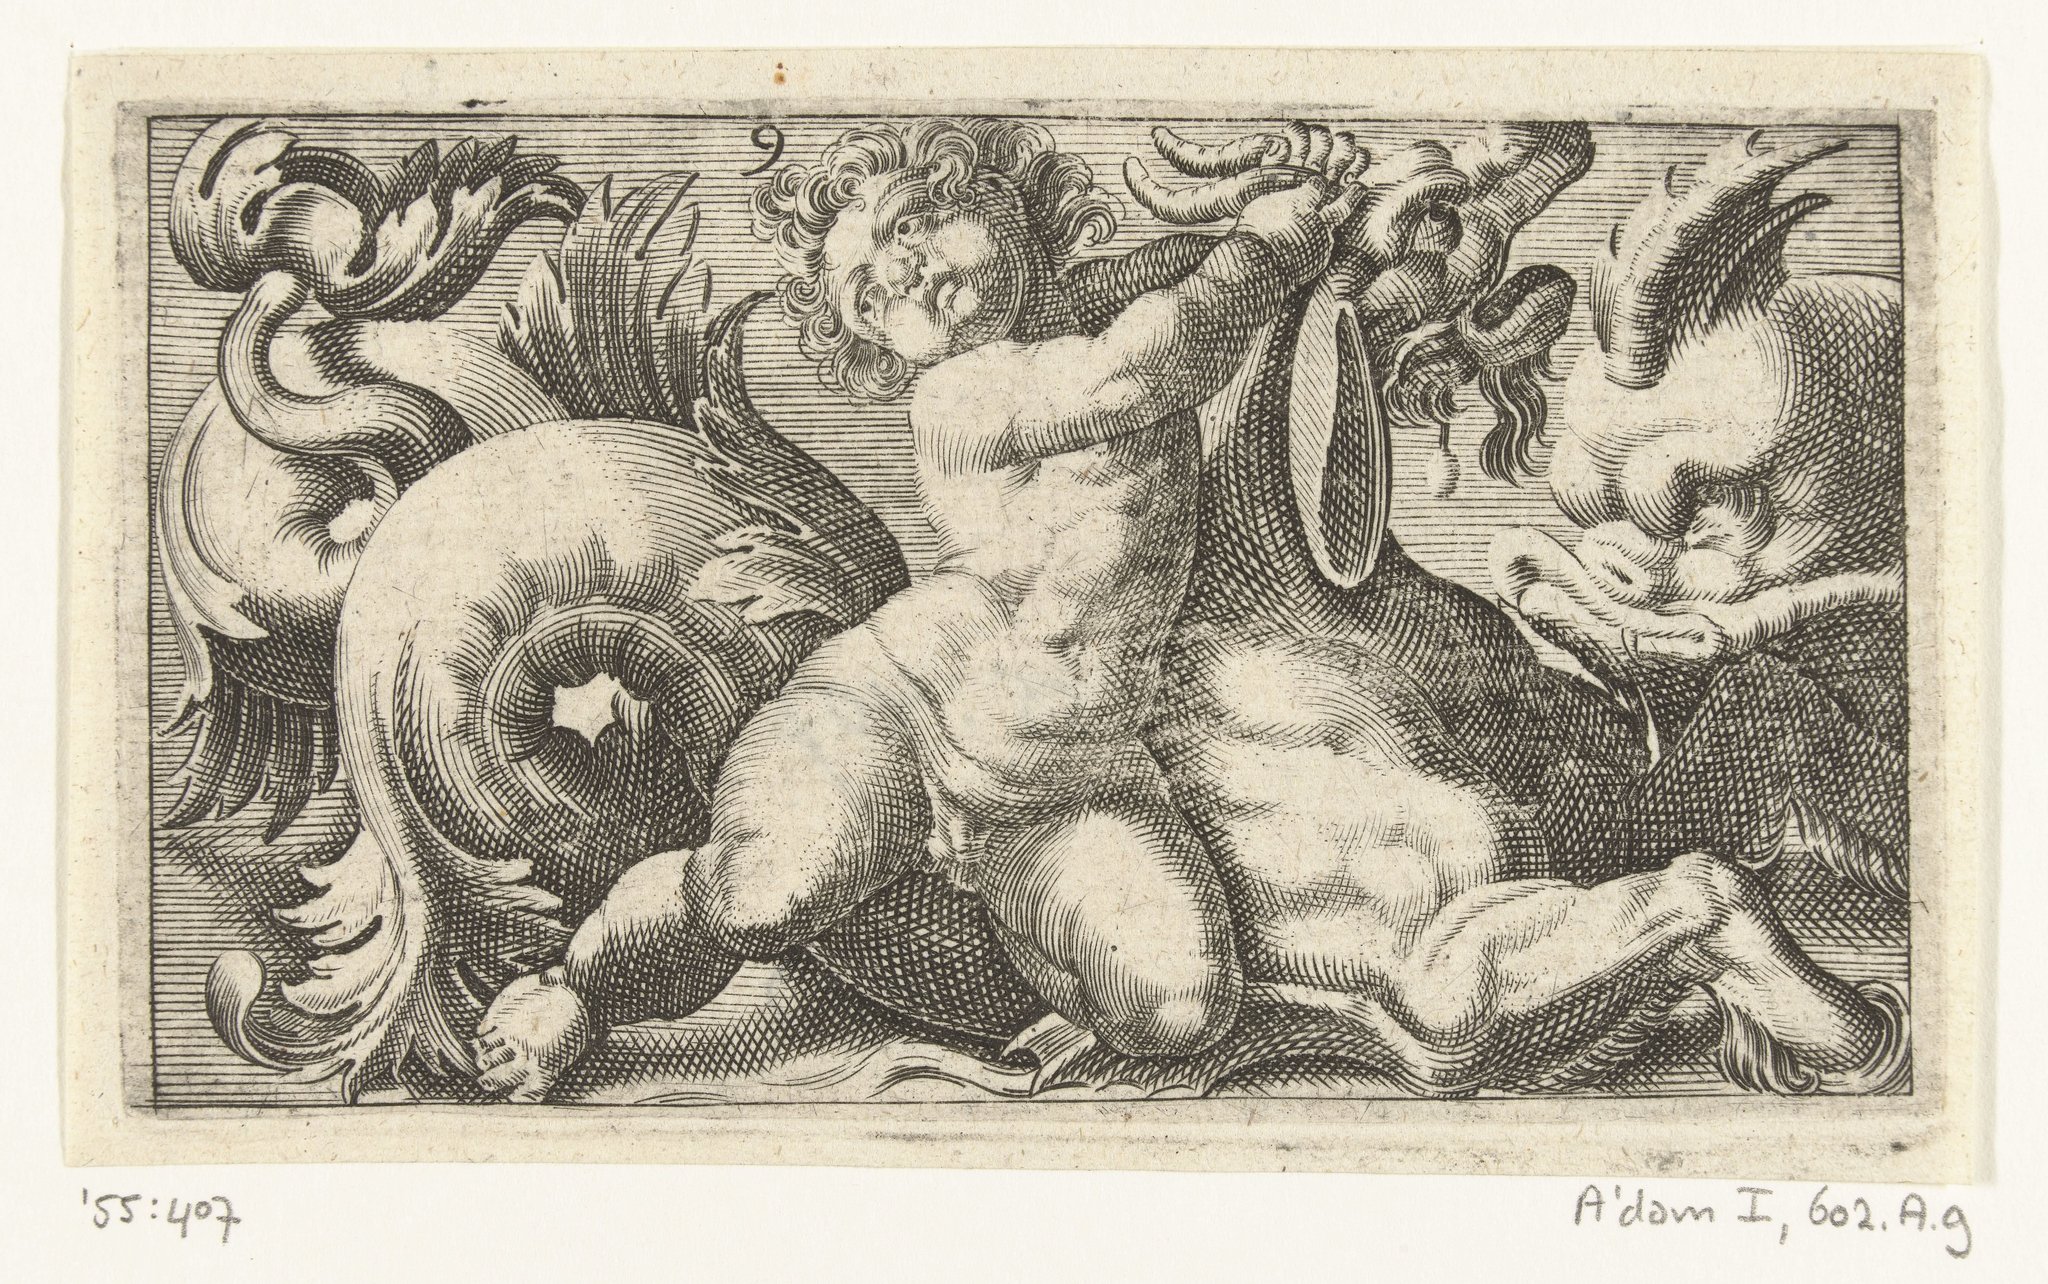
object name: print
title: Putti op zeewezens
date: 1605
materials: paper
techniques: engraving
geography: germany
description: Tegenzijdige kopie naar een prent van Giovanni Andrea Maglioli.